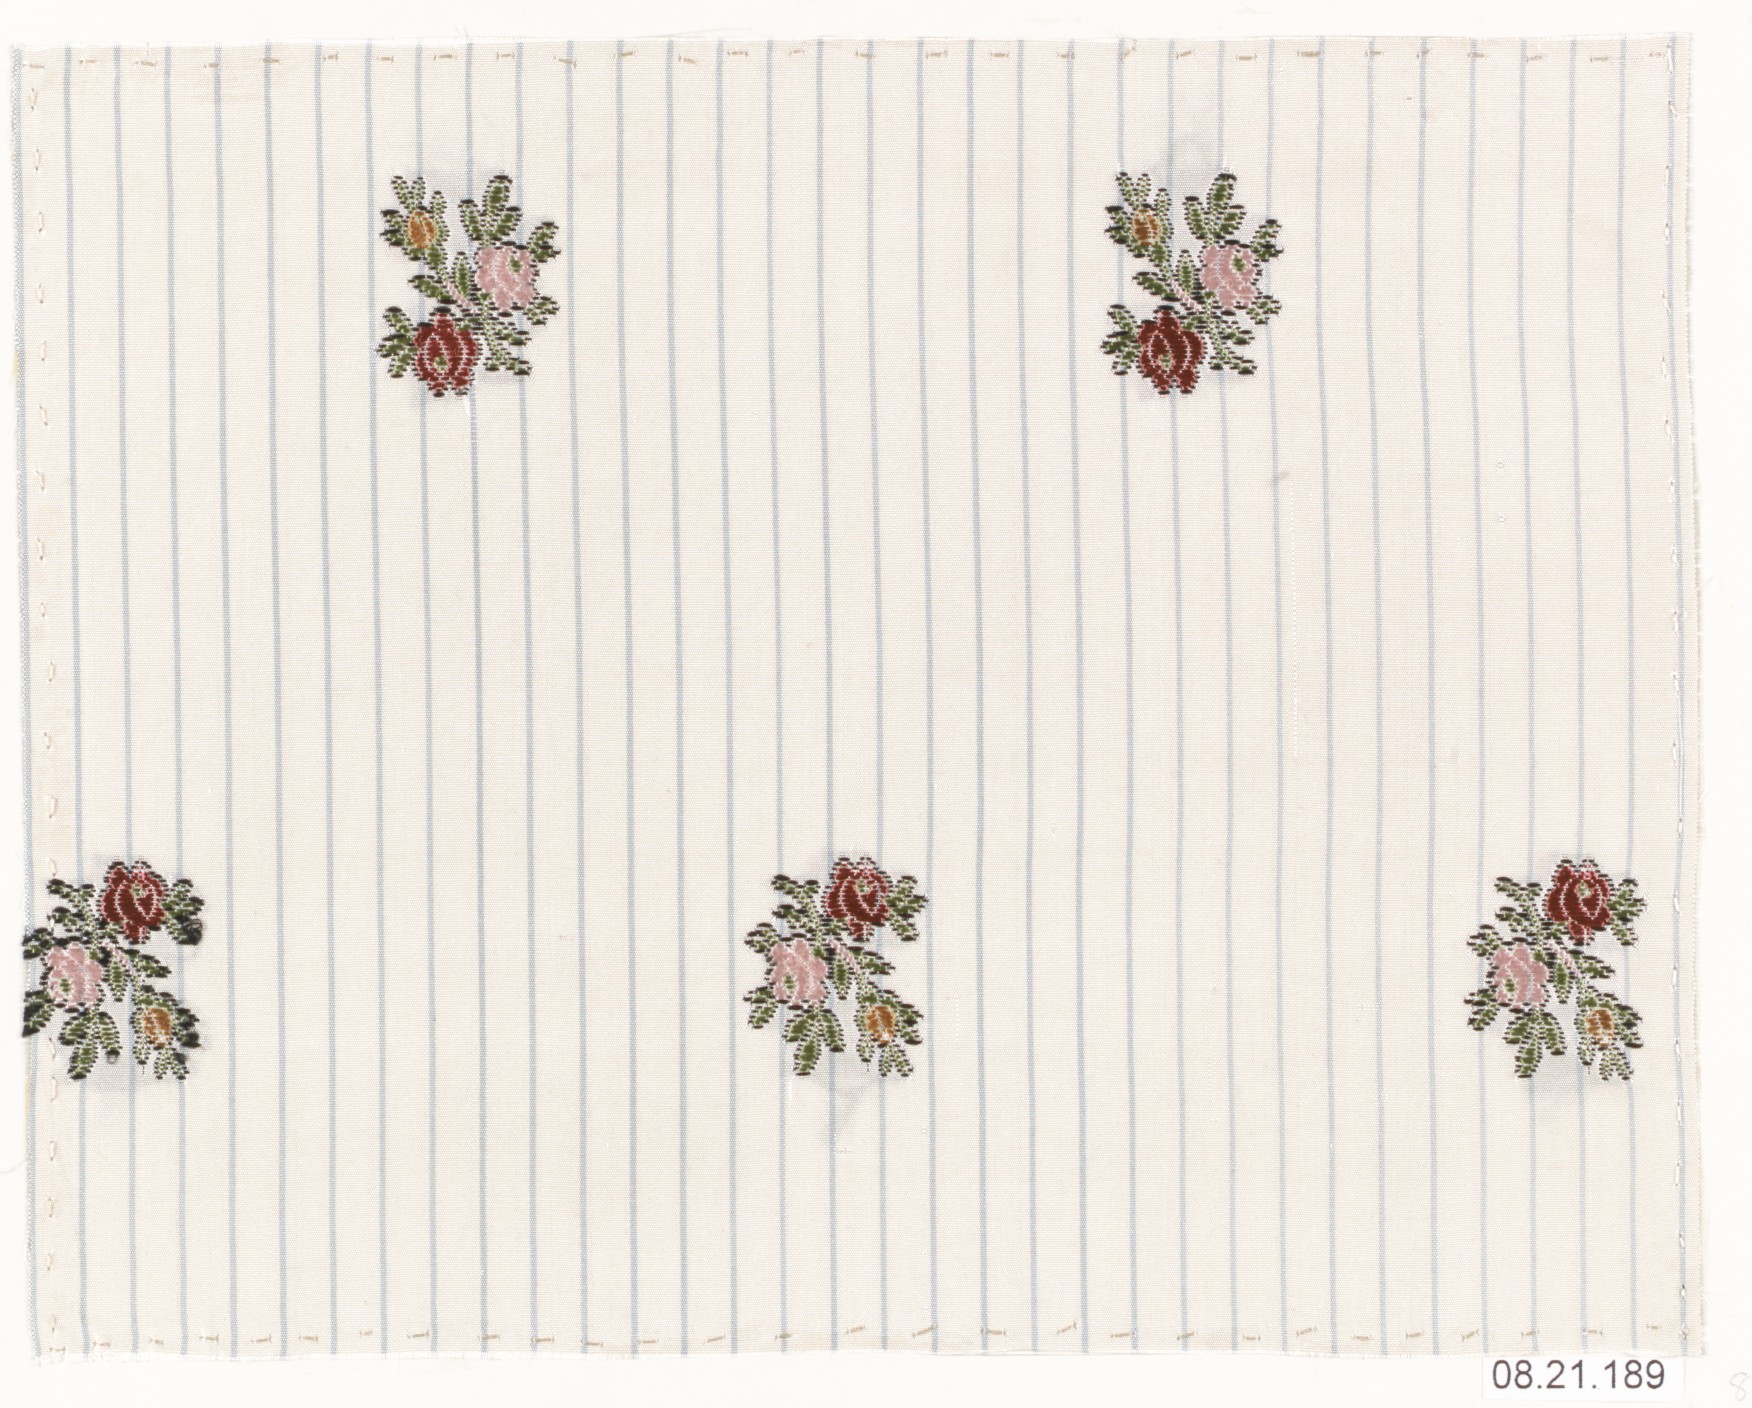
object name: textile sample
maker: Anonymous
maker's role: designer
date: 1900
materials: silk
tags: flowers